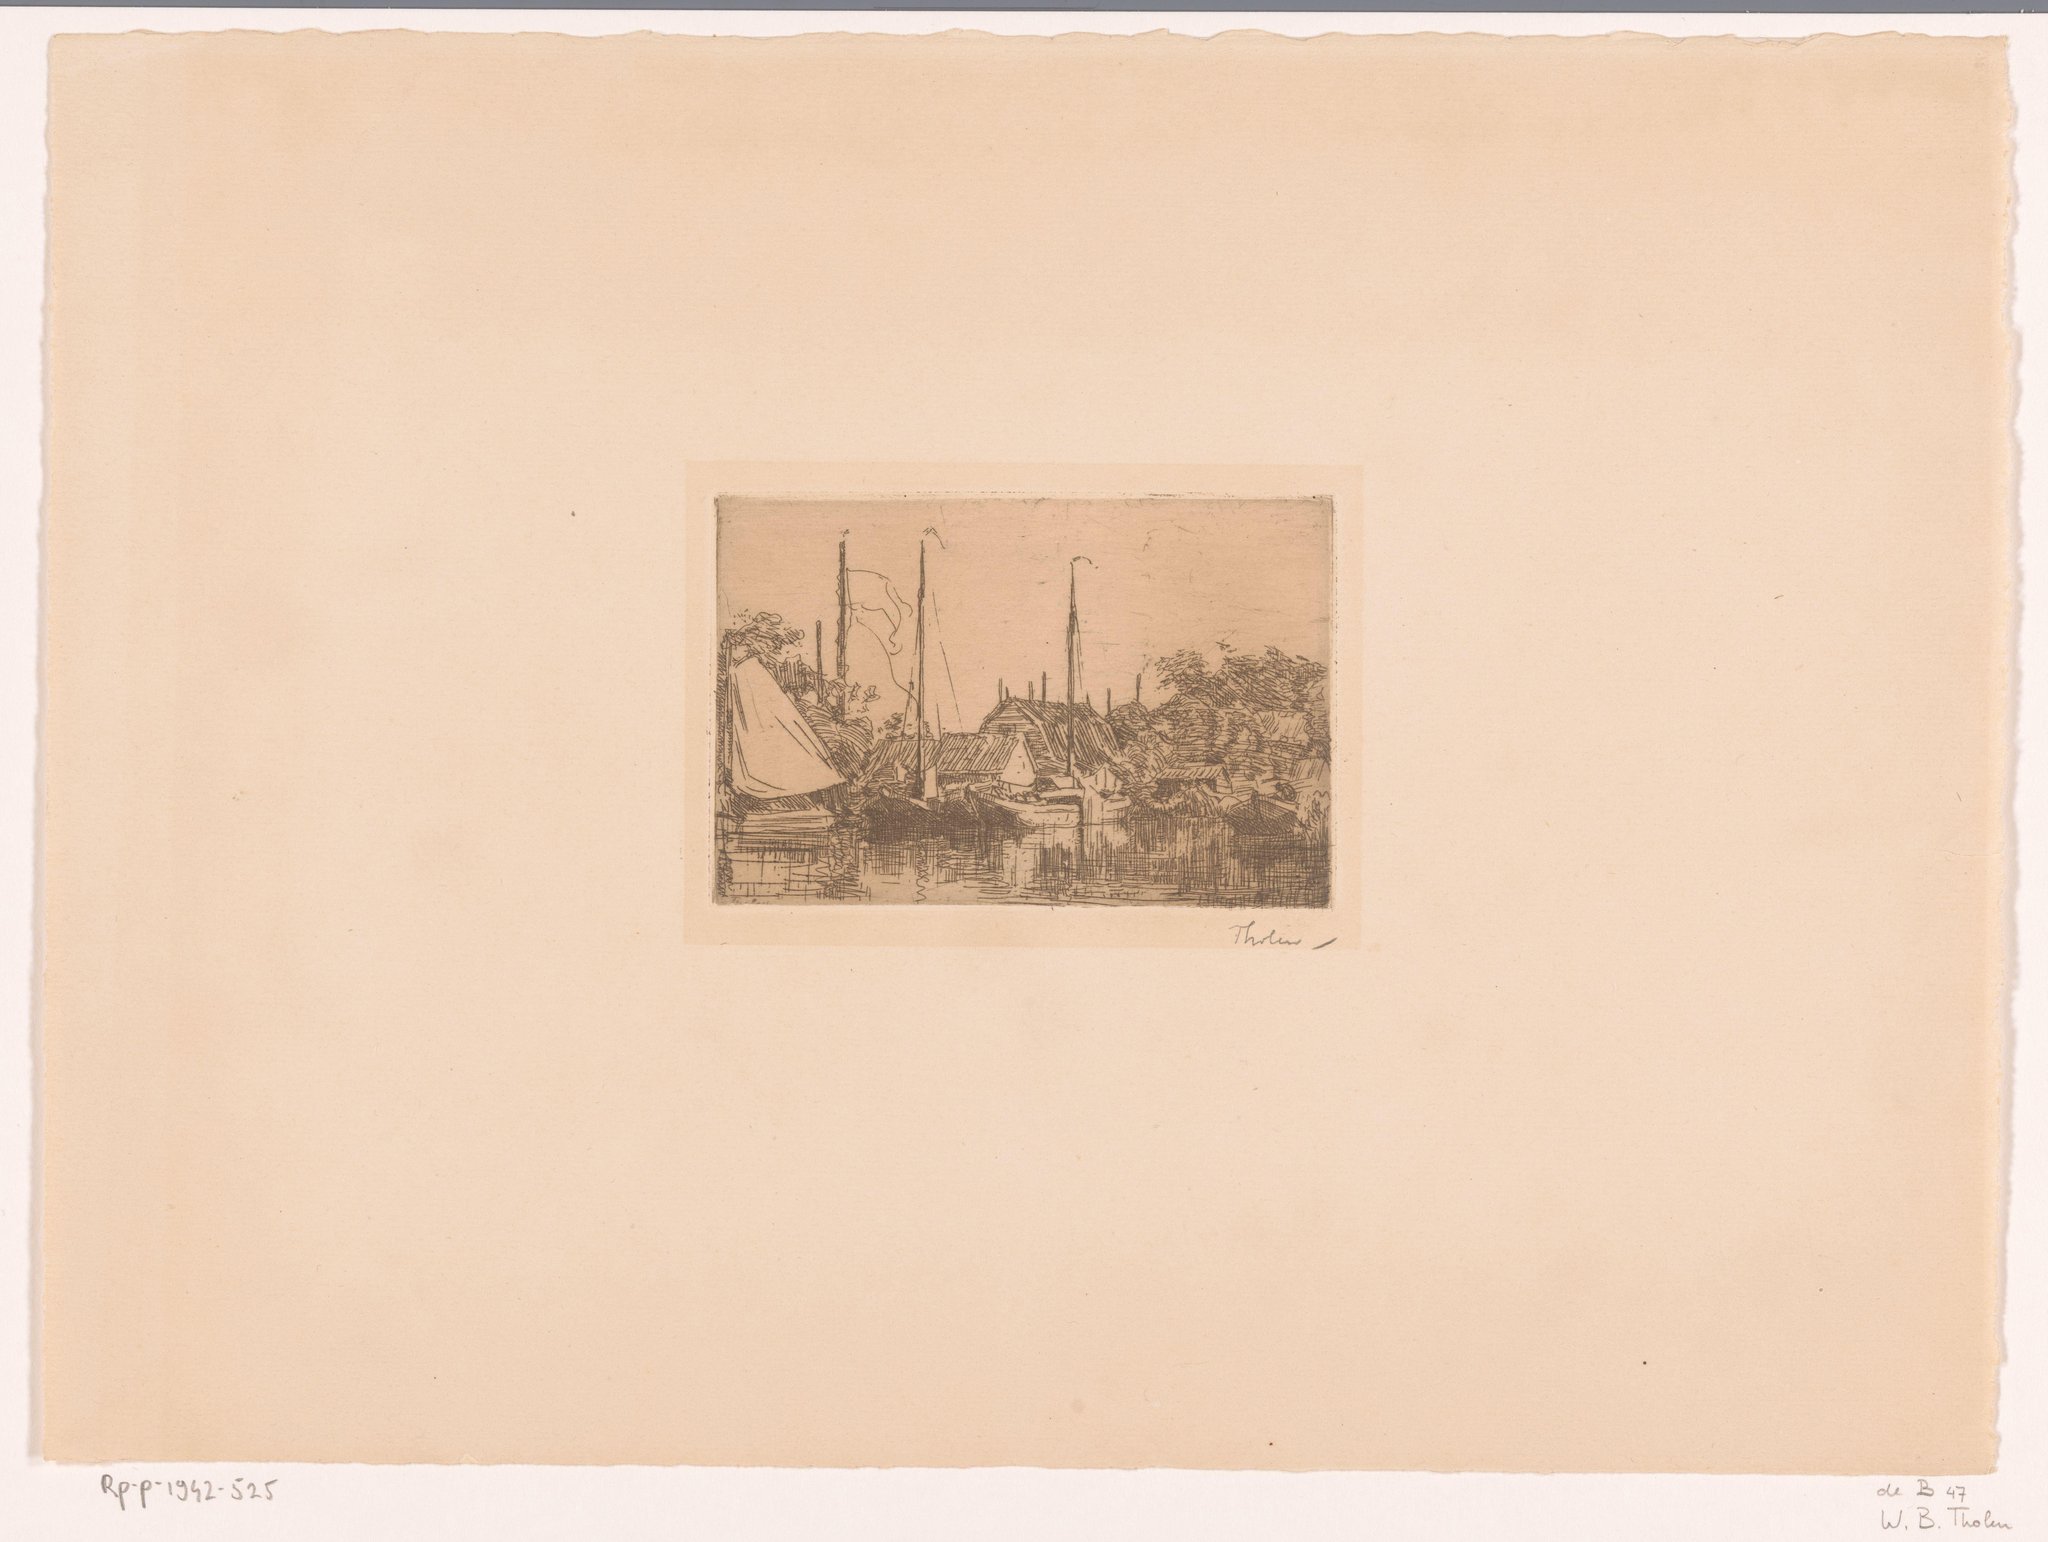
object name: print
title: Aangemeerde boten, aan de waterkant bomen en huizen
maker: willem bastiaan tholen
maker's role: draughtsman, painter, print maker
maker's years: 1860-1931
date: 1870-1914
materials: paper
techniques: etching, intaglio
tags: sailing-ship, sailing-boat, lake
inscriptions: collector's mark: Lugt 2228